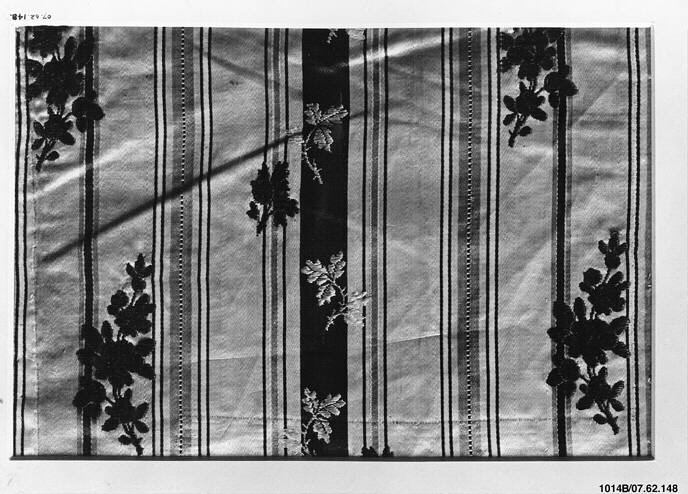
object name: piece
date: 1701-1800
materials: silk